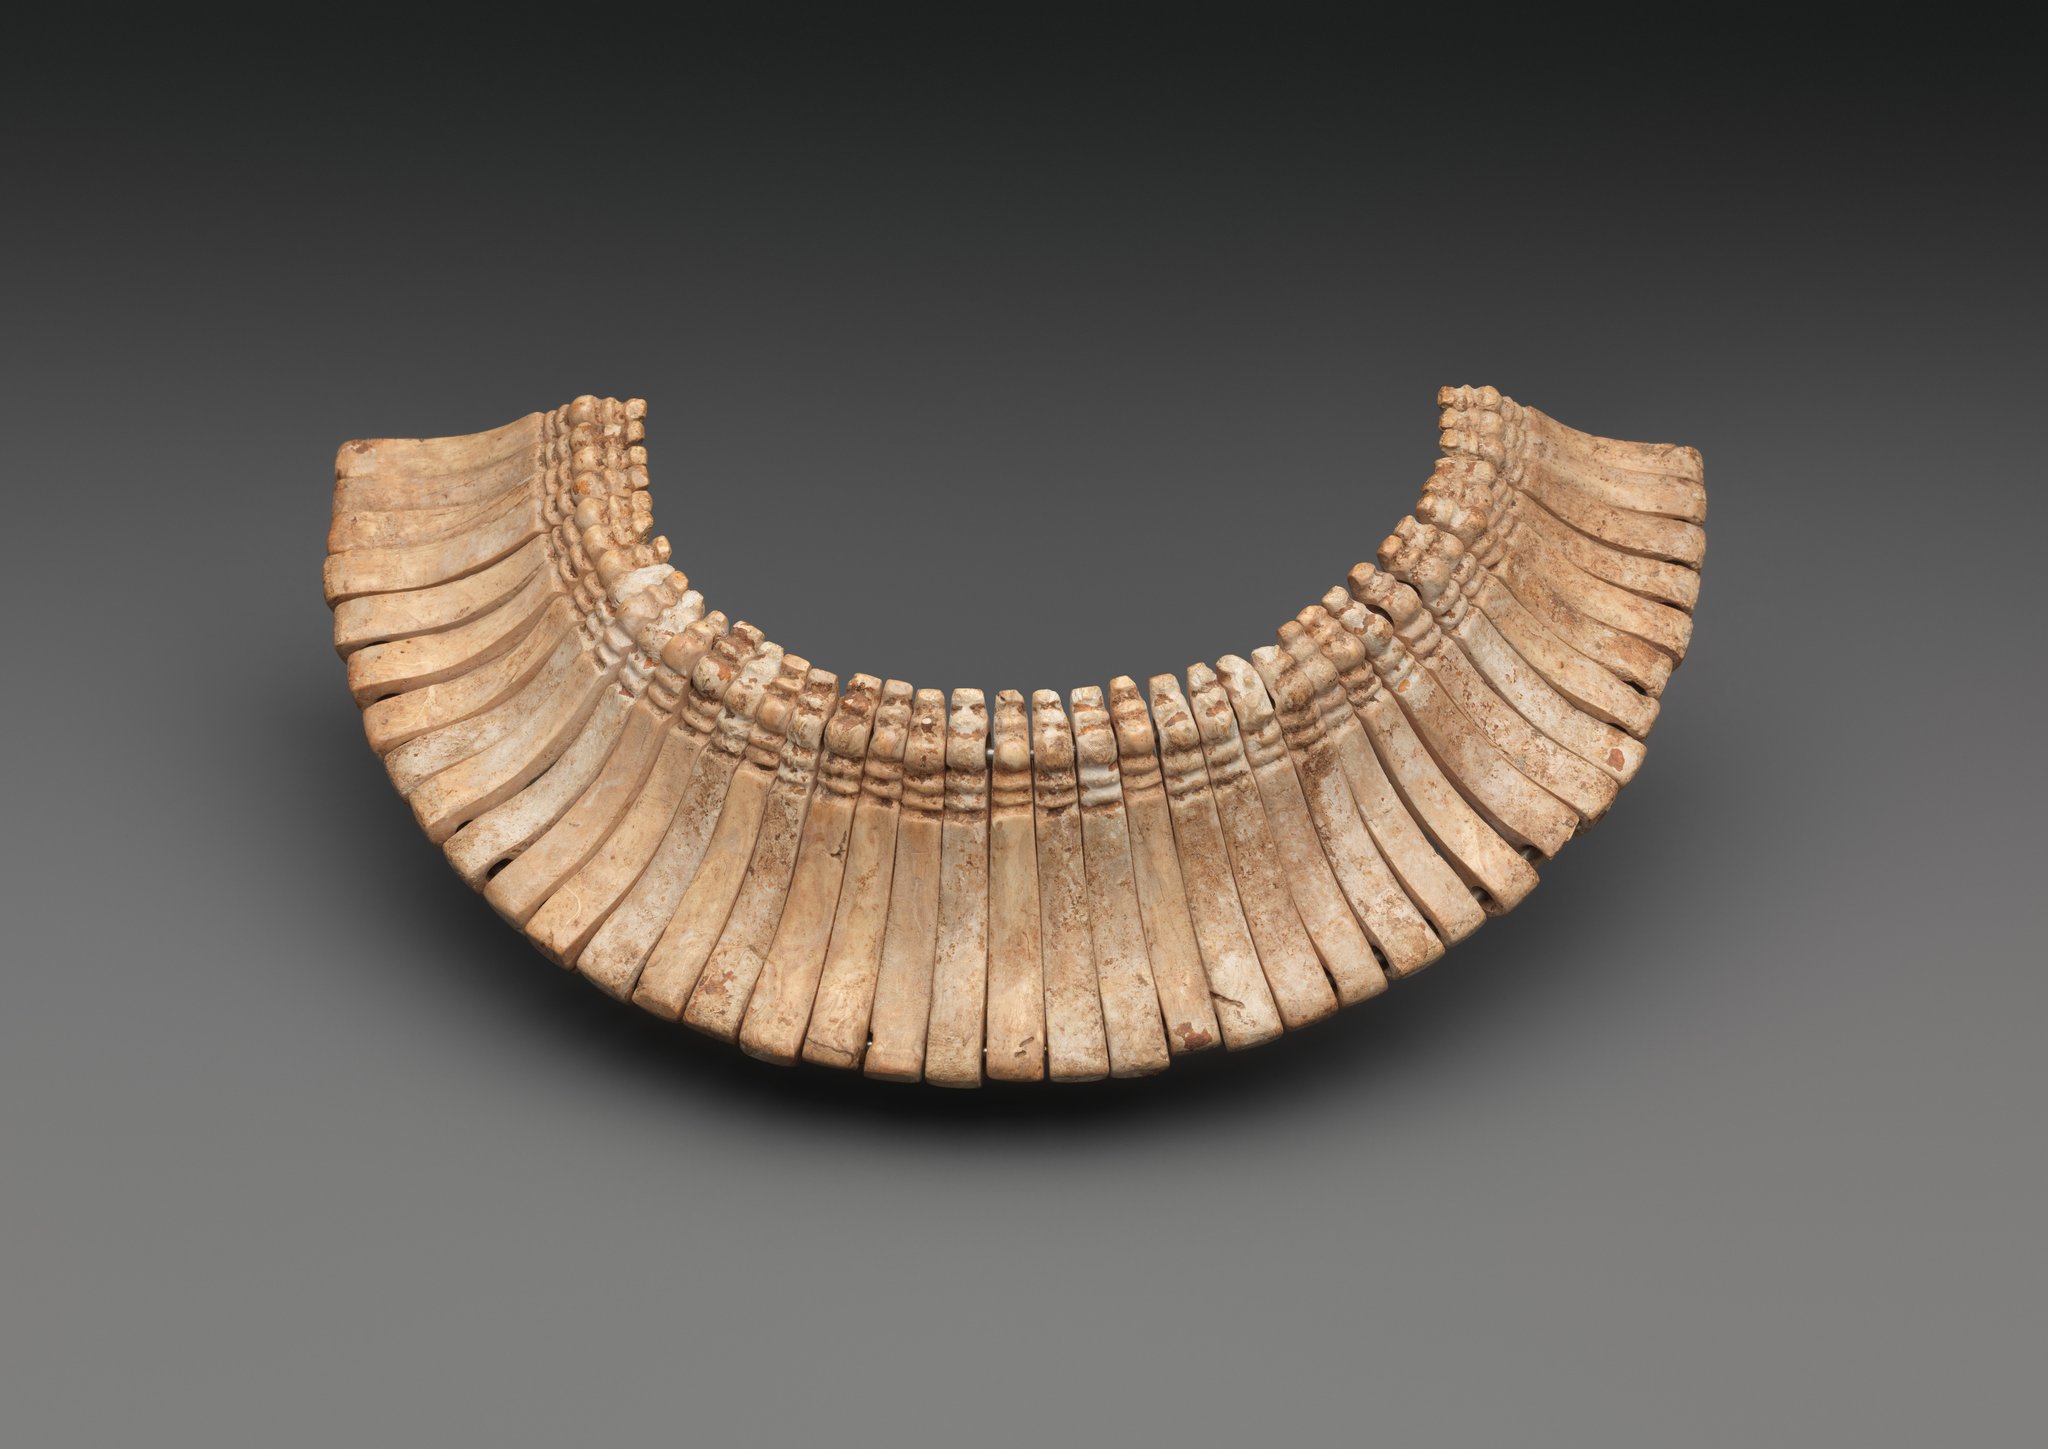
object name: necklace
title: Shell Necklace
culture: venado beach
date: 401-1000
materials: shell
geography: panama